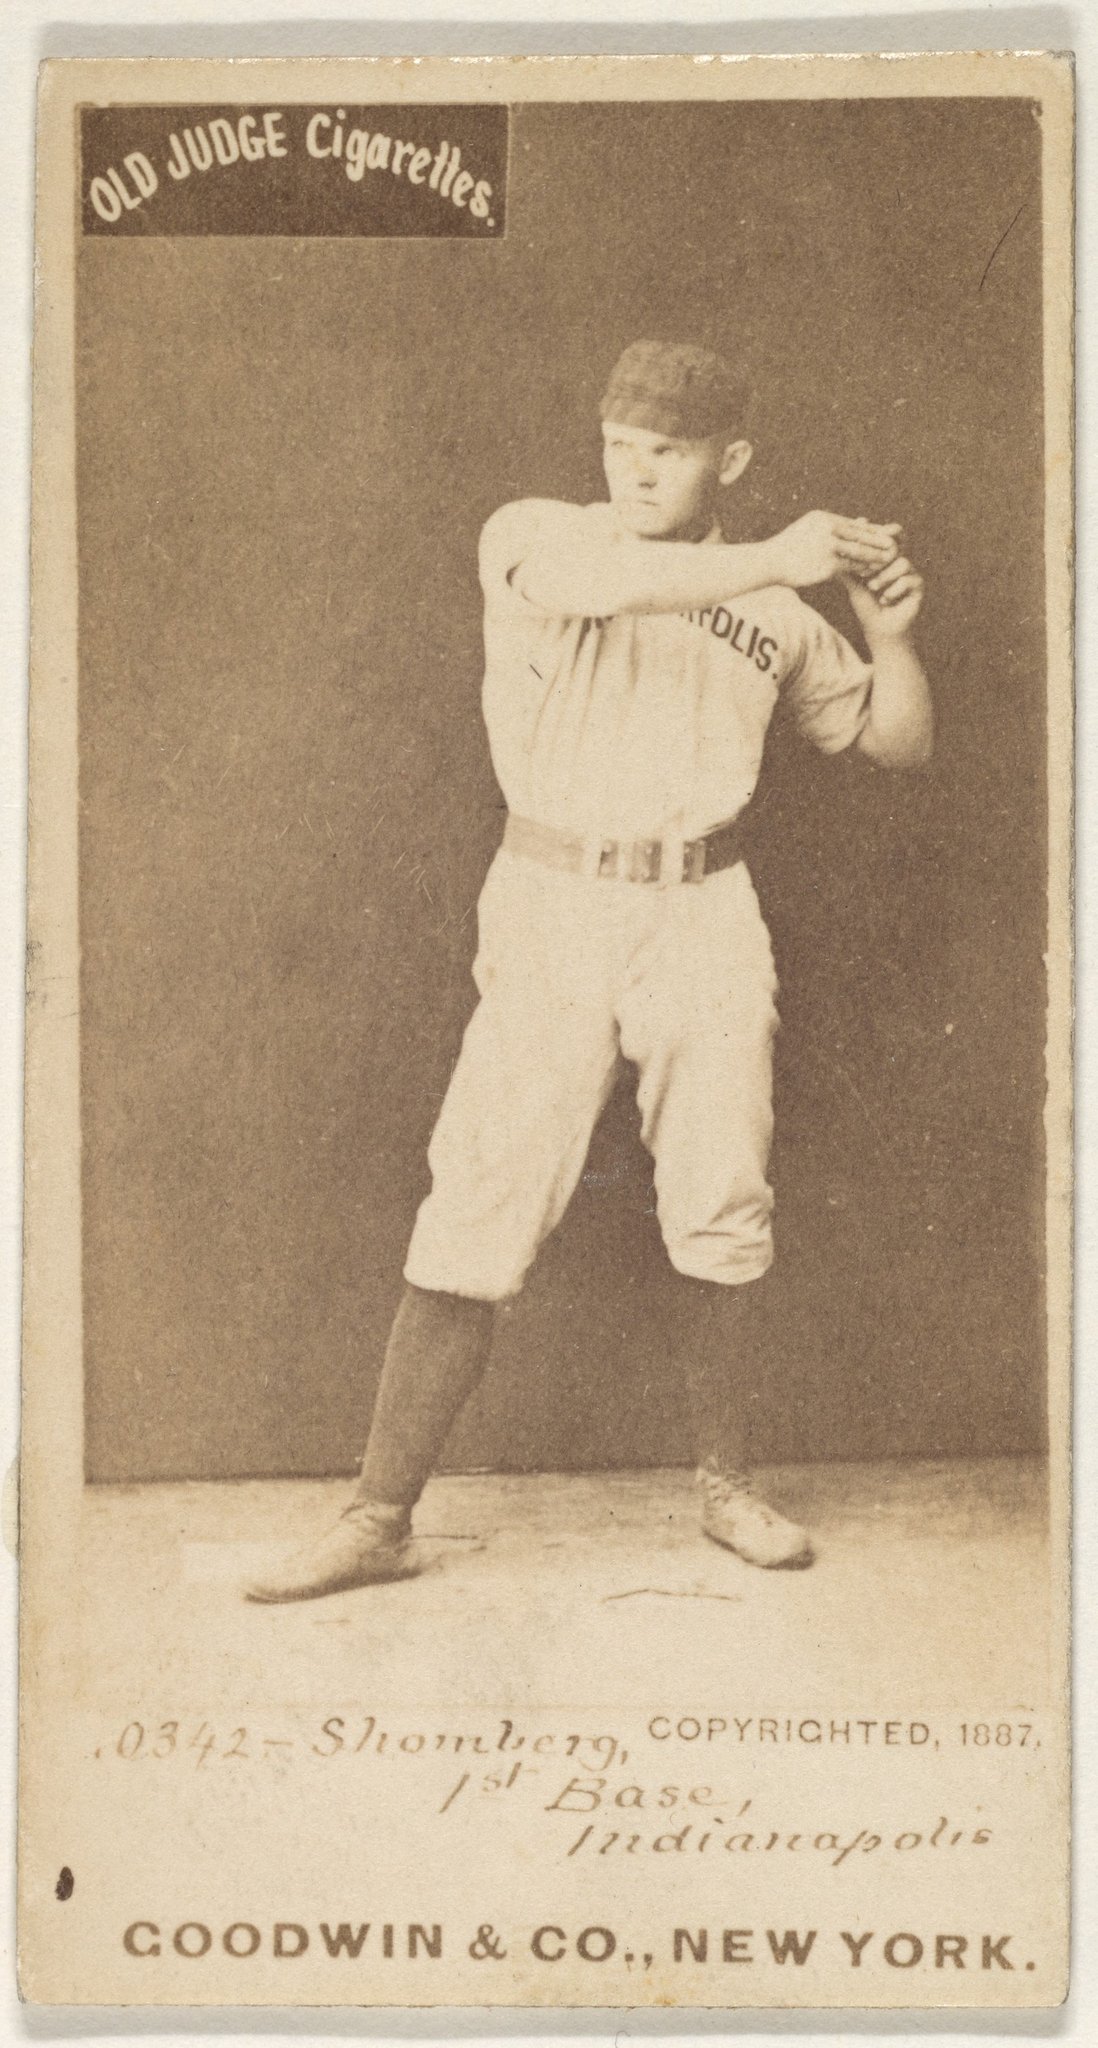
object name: baseball card, photograph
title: Shomberg, 1st Base, Indianapolis, from the Old Judge series (N172) for Old Judge Cigarettes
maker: goodwin & company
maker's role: publisher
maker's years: 1850-1950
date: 1887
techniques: albumen silver print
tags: men,portraits,baseball,athletes